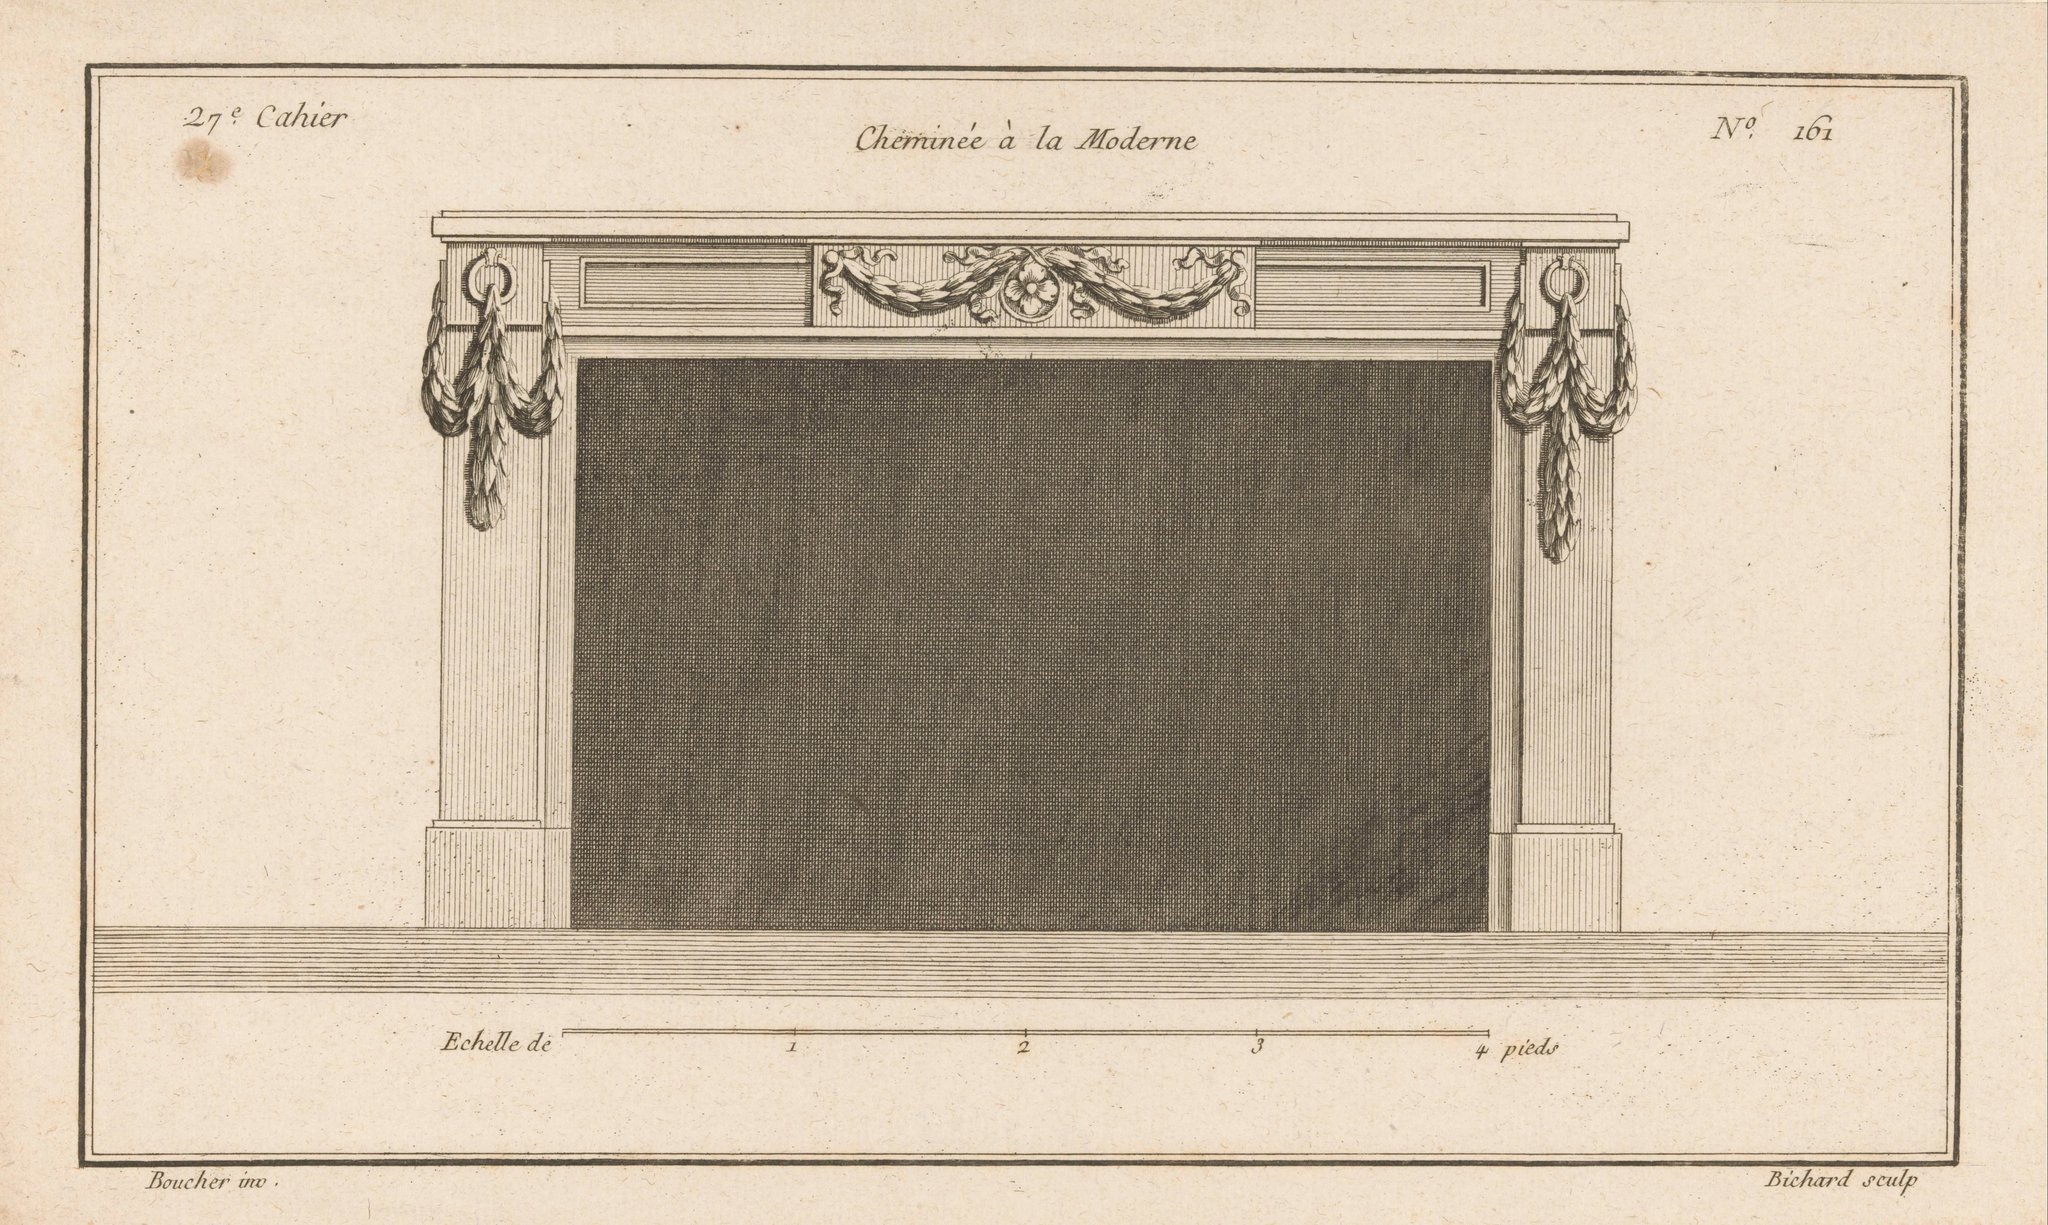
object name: ornament print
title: Cheminée à la Moderne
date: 1772-1779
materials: paper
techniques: engraving, etching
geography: paris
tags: open hearth, fire-place, ornament ~ festoon, garland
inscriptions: collector's mark: Lugt 2760, collector's mark: Lugt 2228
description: Een open haard gedecoreerd met guirlandes. Prentnummer 161.